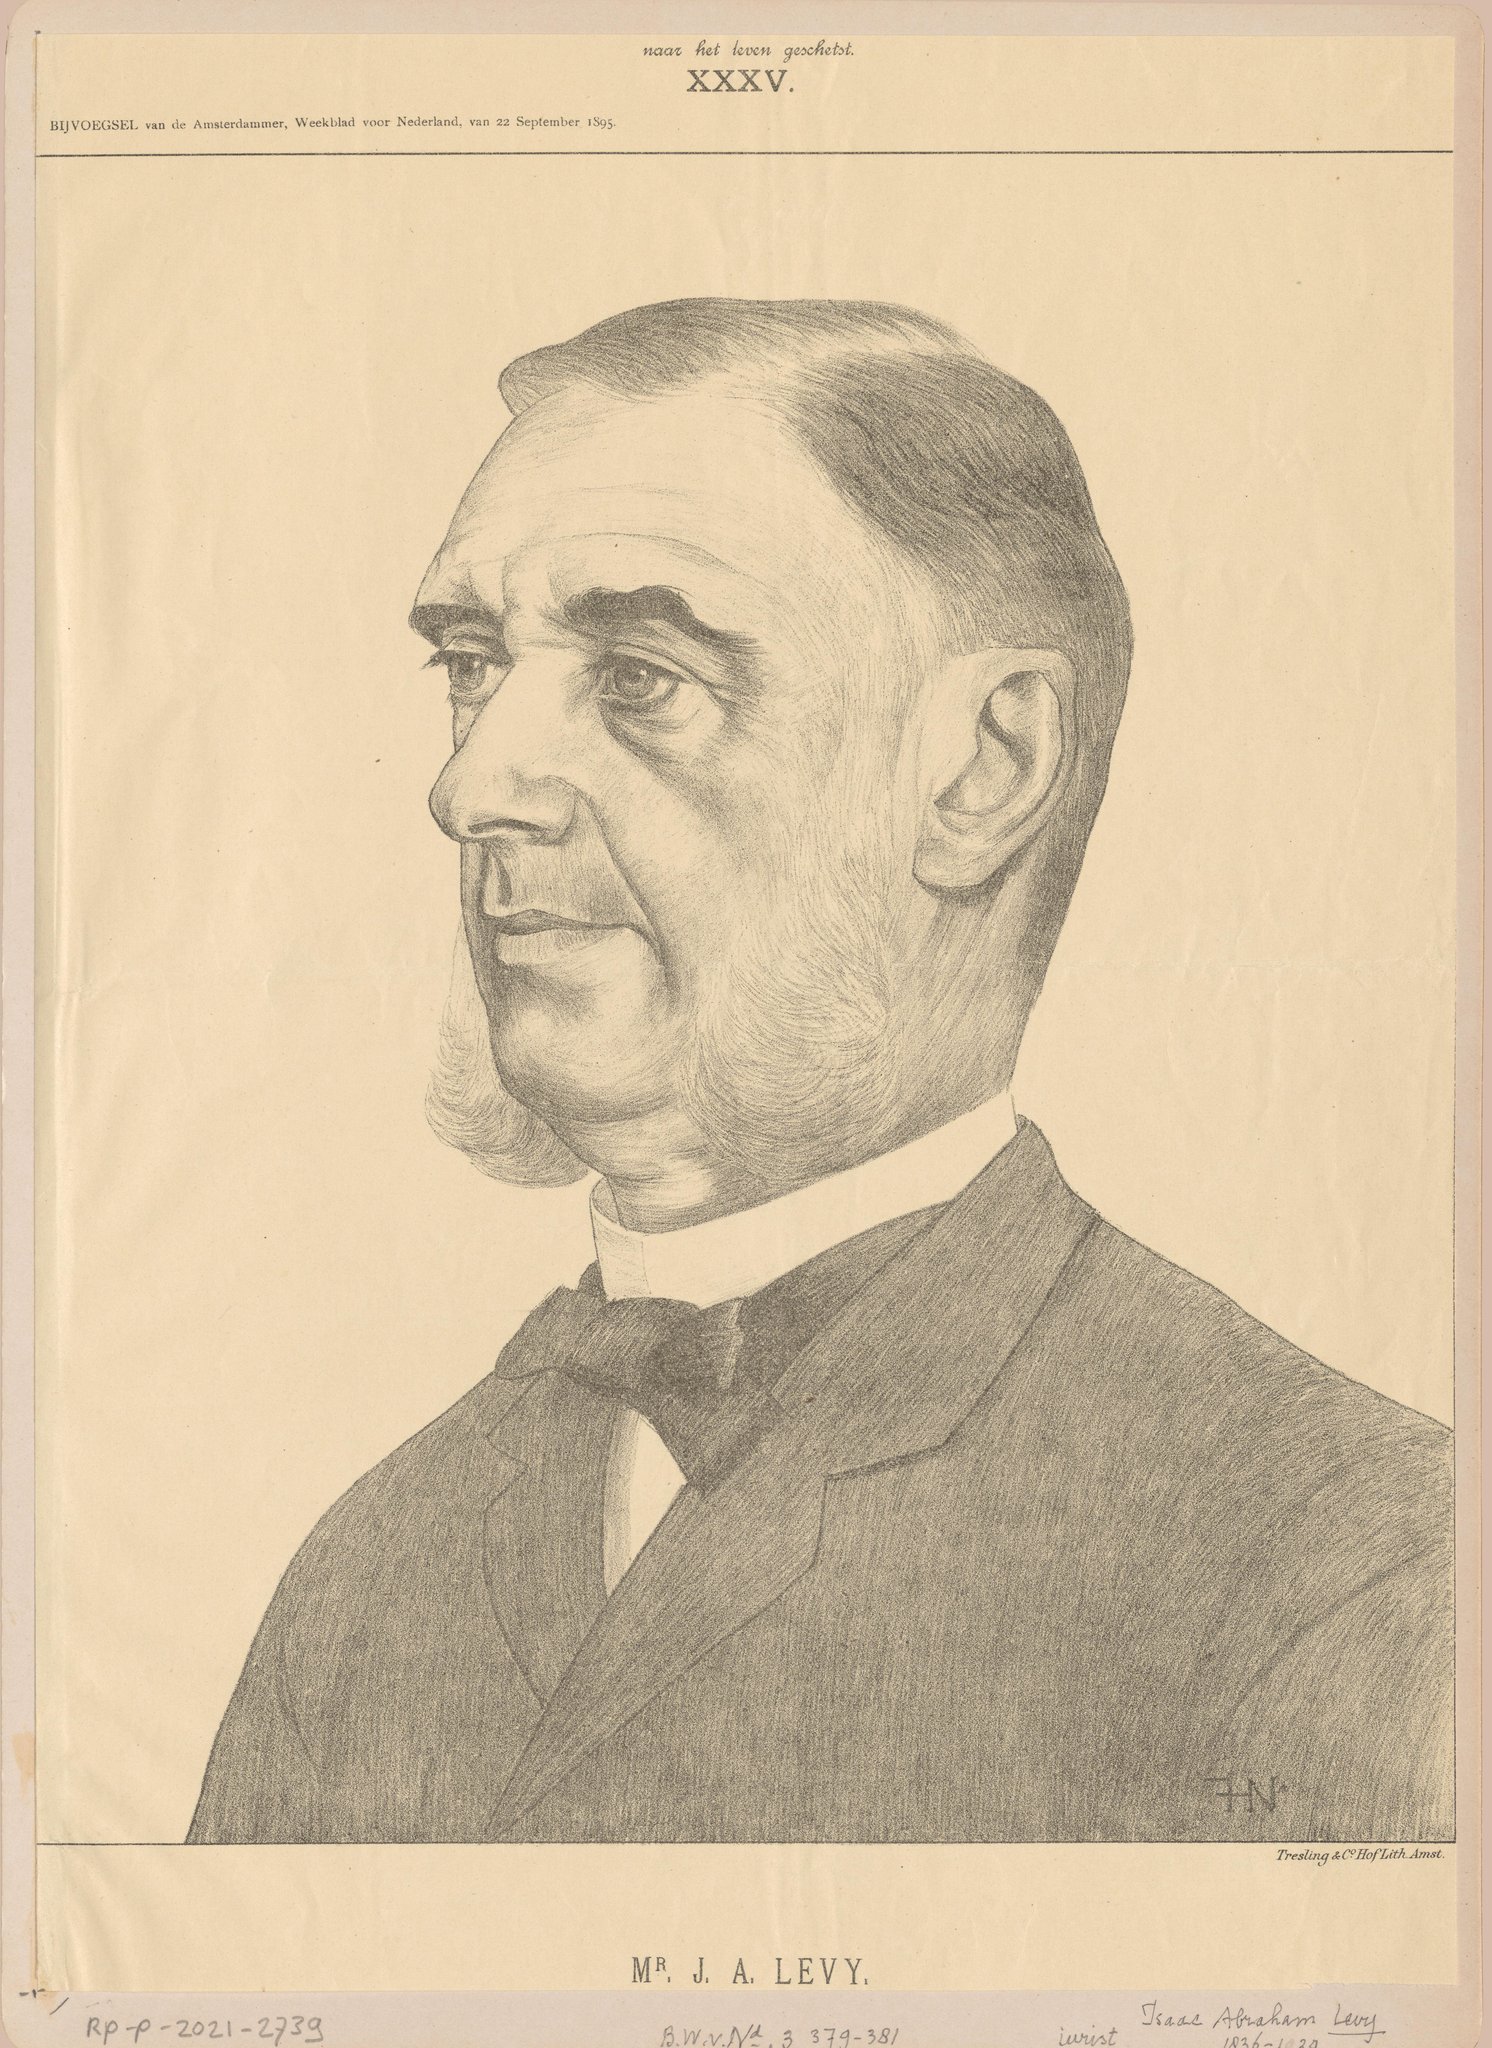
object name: print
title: Bekende tijdgenooten naar het leven geschetst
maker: ferdinand hart nibbrig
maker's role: draughtsman, painter, print maker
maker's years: 1866-1915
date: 1895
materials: paper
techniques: lithograph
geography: amsterdam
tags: amsterdam, politician, historical persons, politician, e.g. party leader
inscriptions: date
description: Prent uit het bijvoegsel van: De Amsterdammer. Weekblad voor Nederland, 22 september 1895.